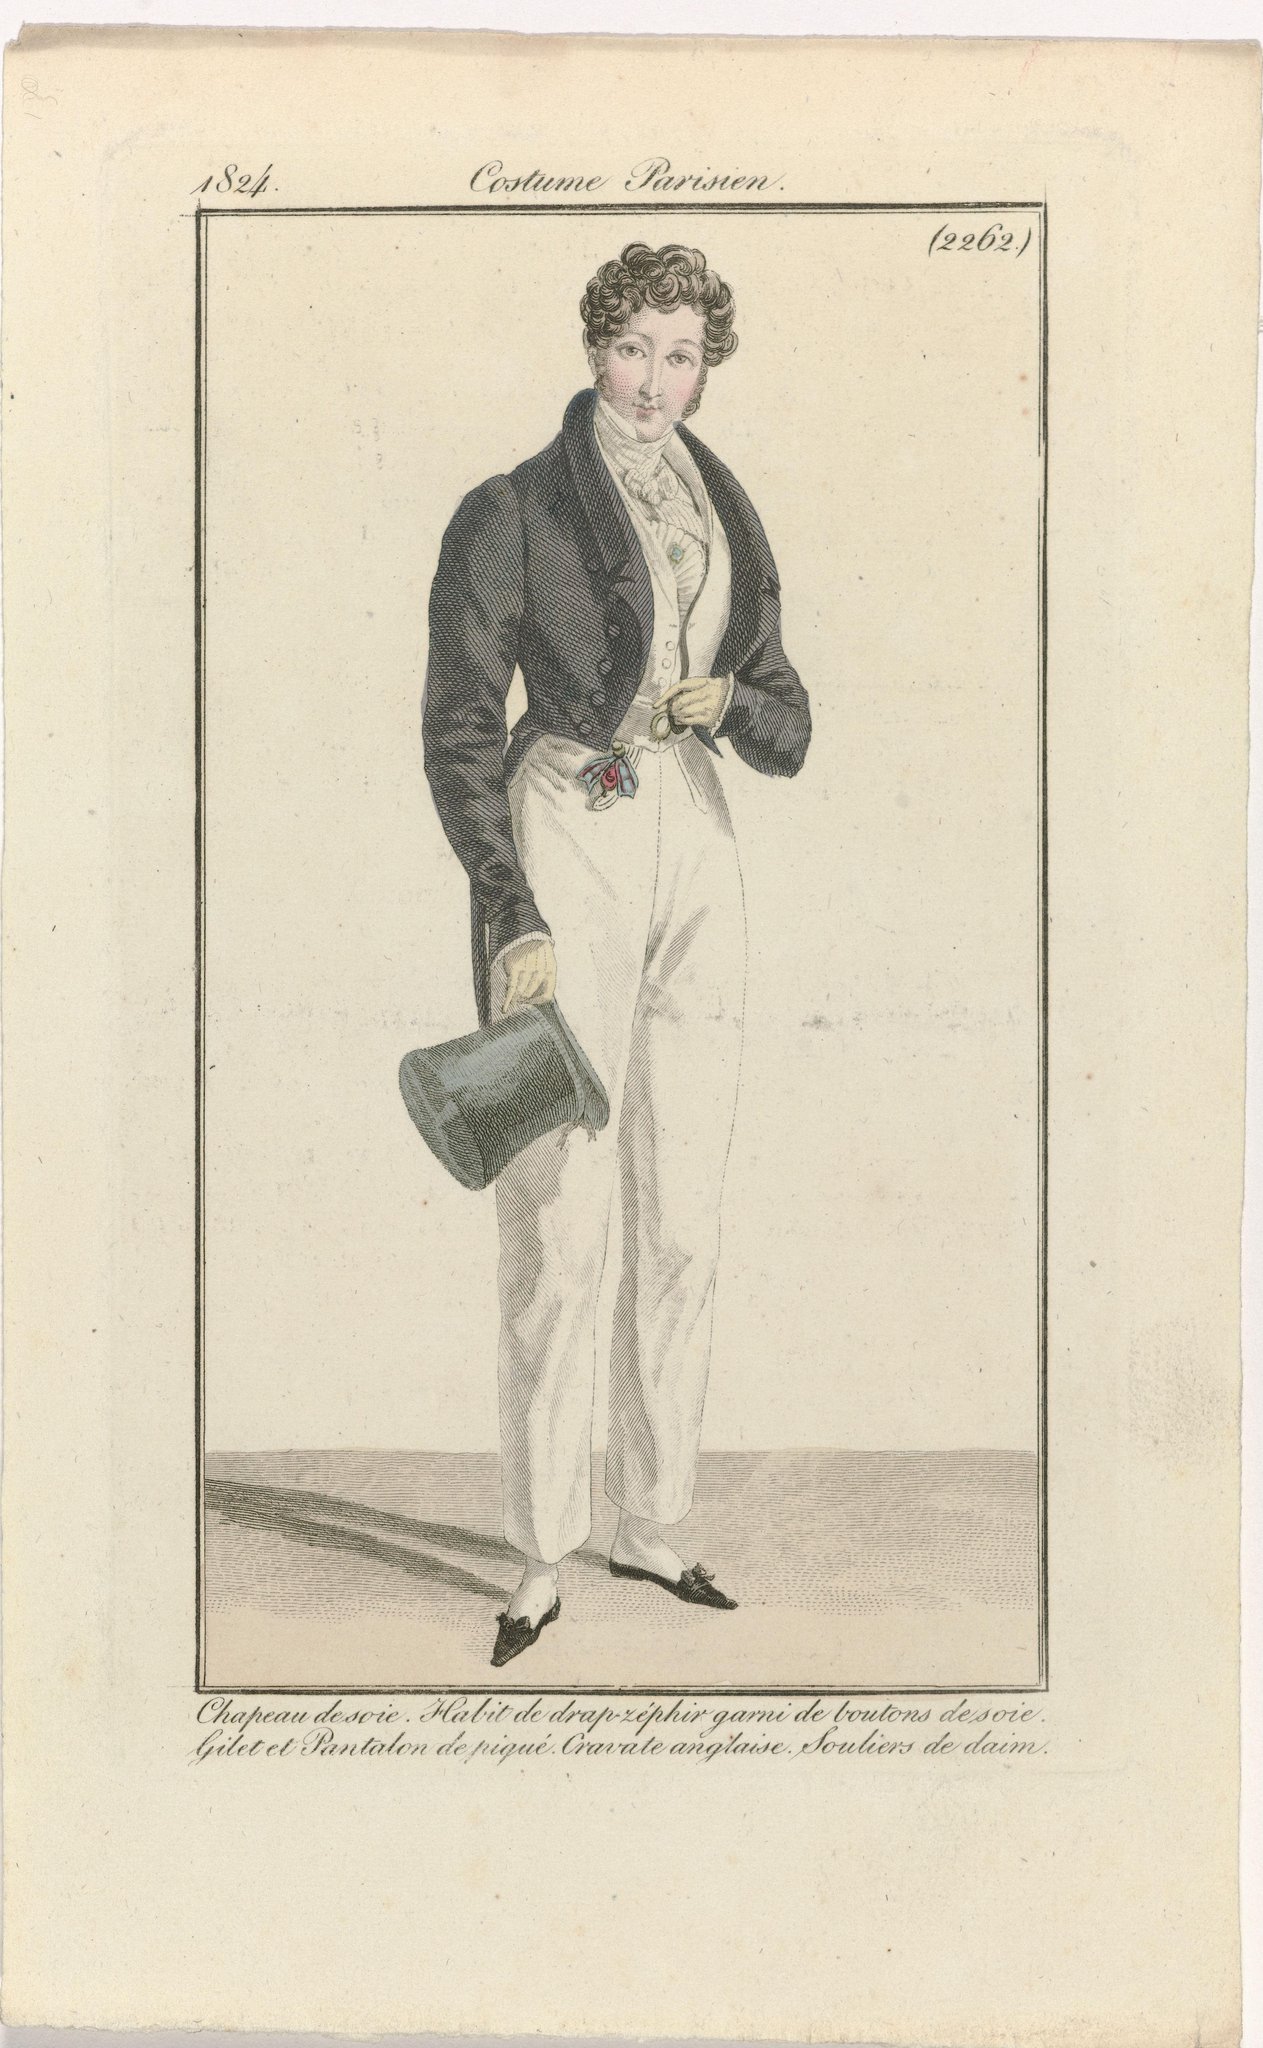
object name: fashion print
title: Journal des Dames et des Modes: Men’s Fashion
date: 1824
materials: paper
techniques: engraving, hand coloring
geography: paris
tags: clothing for the upper part of the body (vest) (+ men's clothes), neck-gear ~ clothing (cravat) (+ men's clothes), monocle, single lorgnette (+ male human being (not to be used where -a- is prescribed)), trousers, breeches, etc. (pantalon) (+ men's clothes), button (+ men's clothes), coat (+ men's clothes), fashion plates, shoes, sandals (+ men's clothes), gloves, mittens, etc. (+ men's clothes), stockings, socks (+ men's clothes)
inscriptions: title: ‘Costume Parisien.’, caption: ‘Chapeau de soie. Habit de drap-zéphir garni de boutons de soie. Gilet et Pantalon de piqué. Cravate anglaise. Souliers de daim.’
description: The Journal des Dames et des Modes occasionally provided coverage of men’s styles. These illustrations give a good picture of trends in mens’ clothing from 1797 to 1825. During the 18th century, gentlemen wore culotte (knee-breeches) 1. These fell out of fashion with the elimination of strict class distinctions during the French Revolution, to be replaced by a type of long trouser(s) known as pantalon à la Hussarde 2. These were worn with hussar boots. ‘Pantaloons’ 3 were trousers pulled tight with an elastic strap under the instep. Carrick 4 coats with a double collar were popular, and in the evenings men wore a special dress cloak 5.